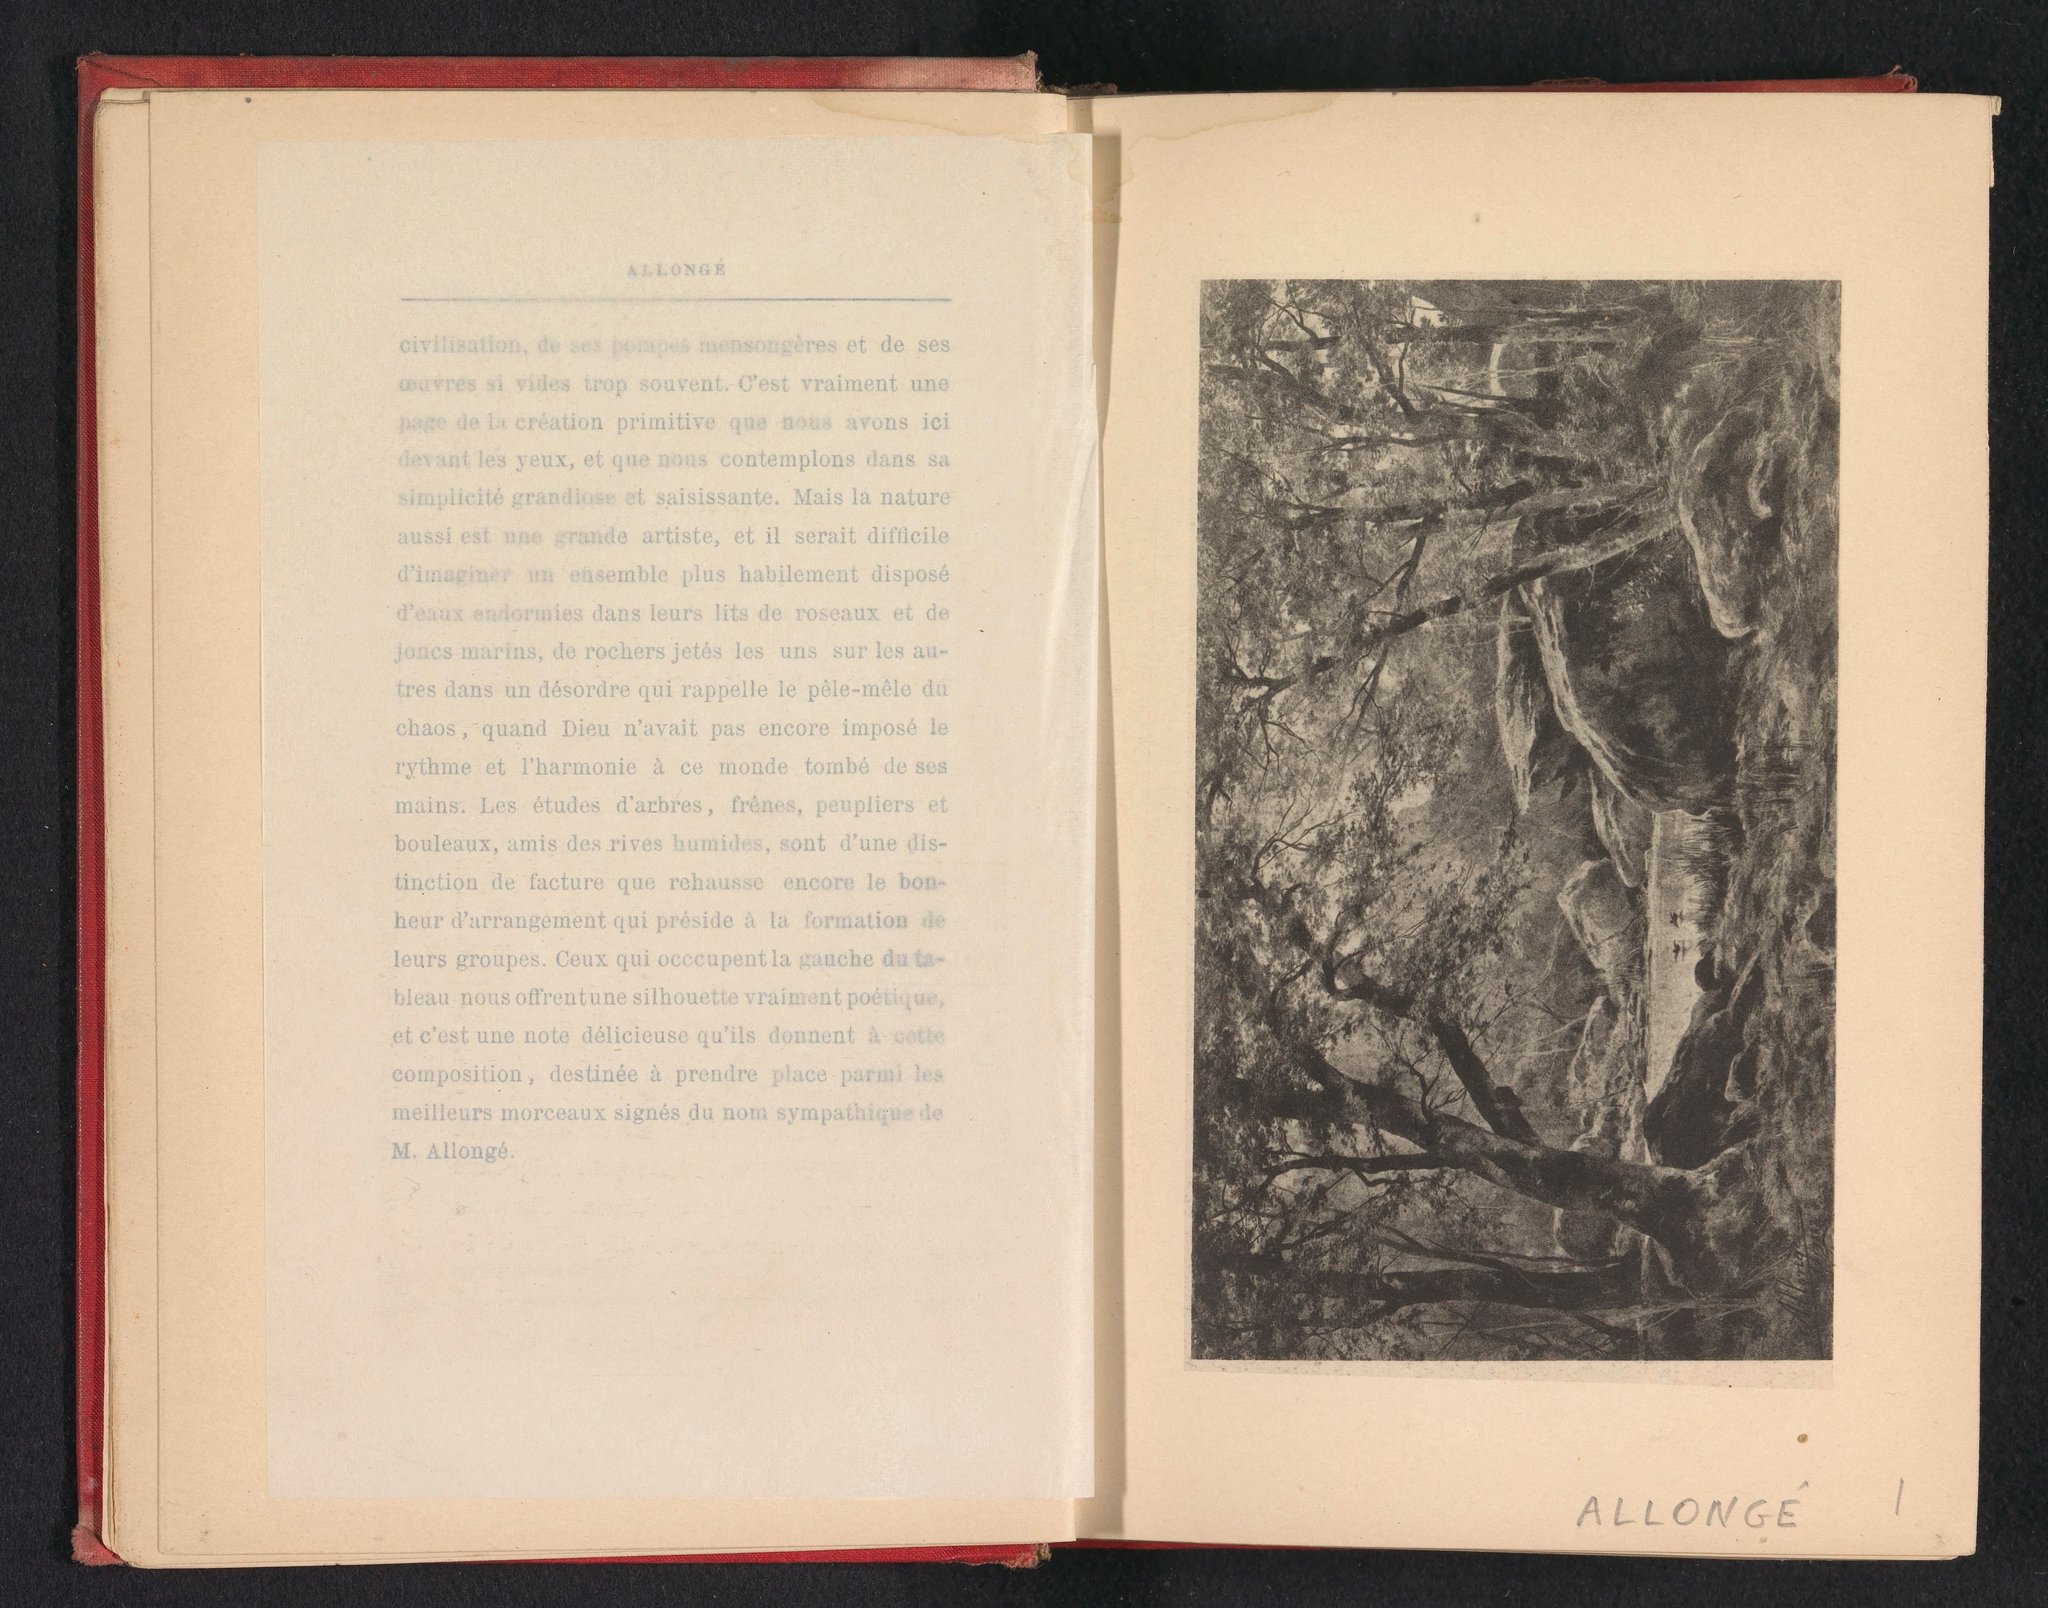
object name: photomechanical print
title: Fotoreproductie van een schilderij, voorstellende een boslandschap met een poel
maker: auguste allongé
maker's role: print maker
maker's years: 1833-1898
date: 1872-1882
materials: paper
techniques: photograph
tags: forest, wood, pond, pool, water-birds: duck